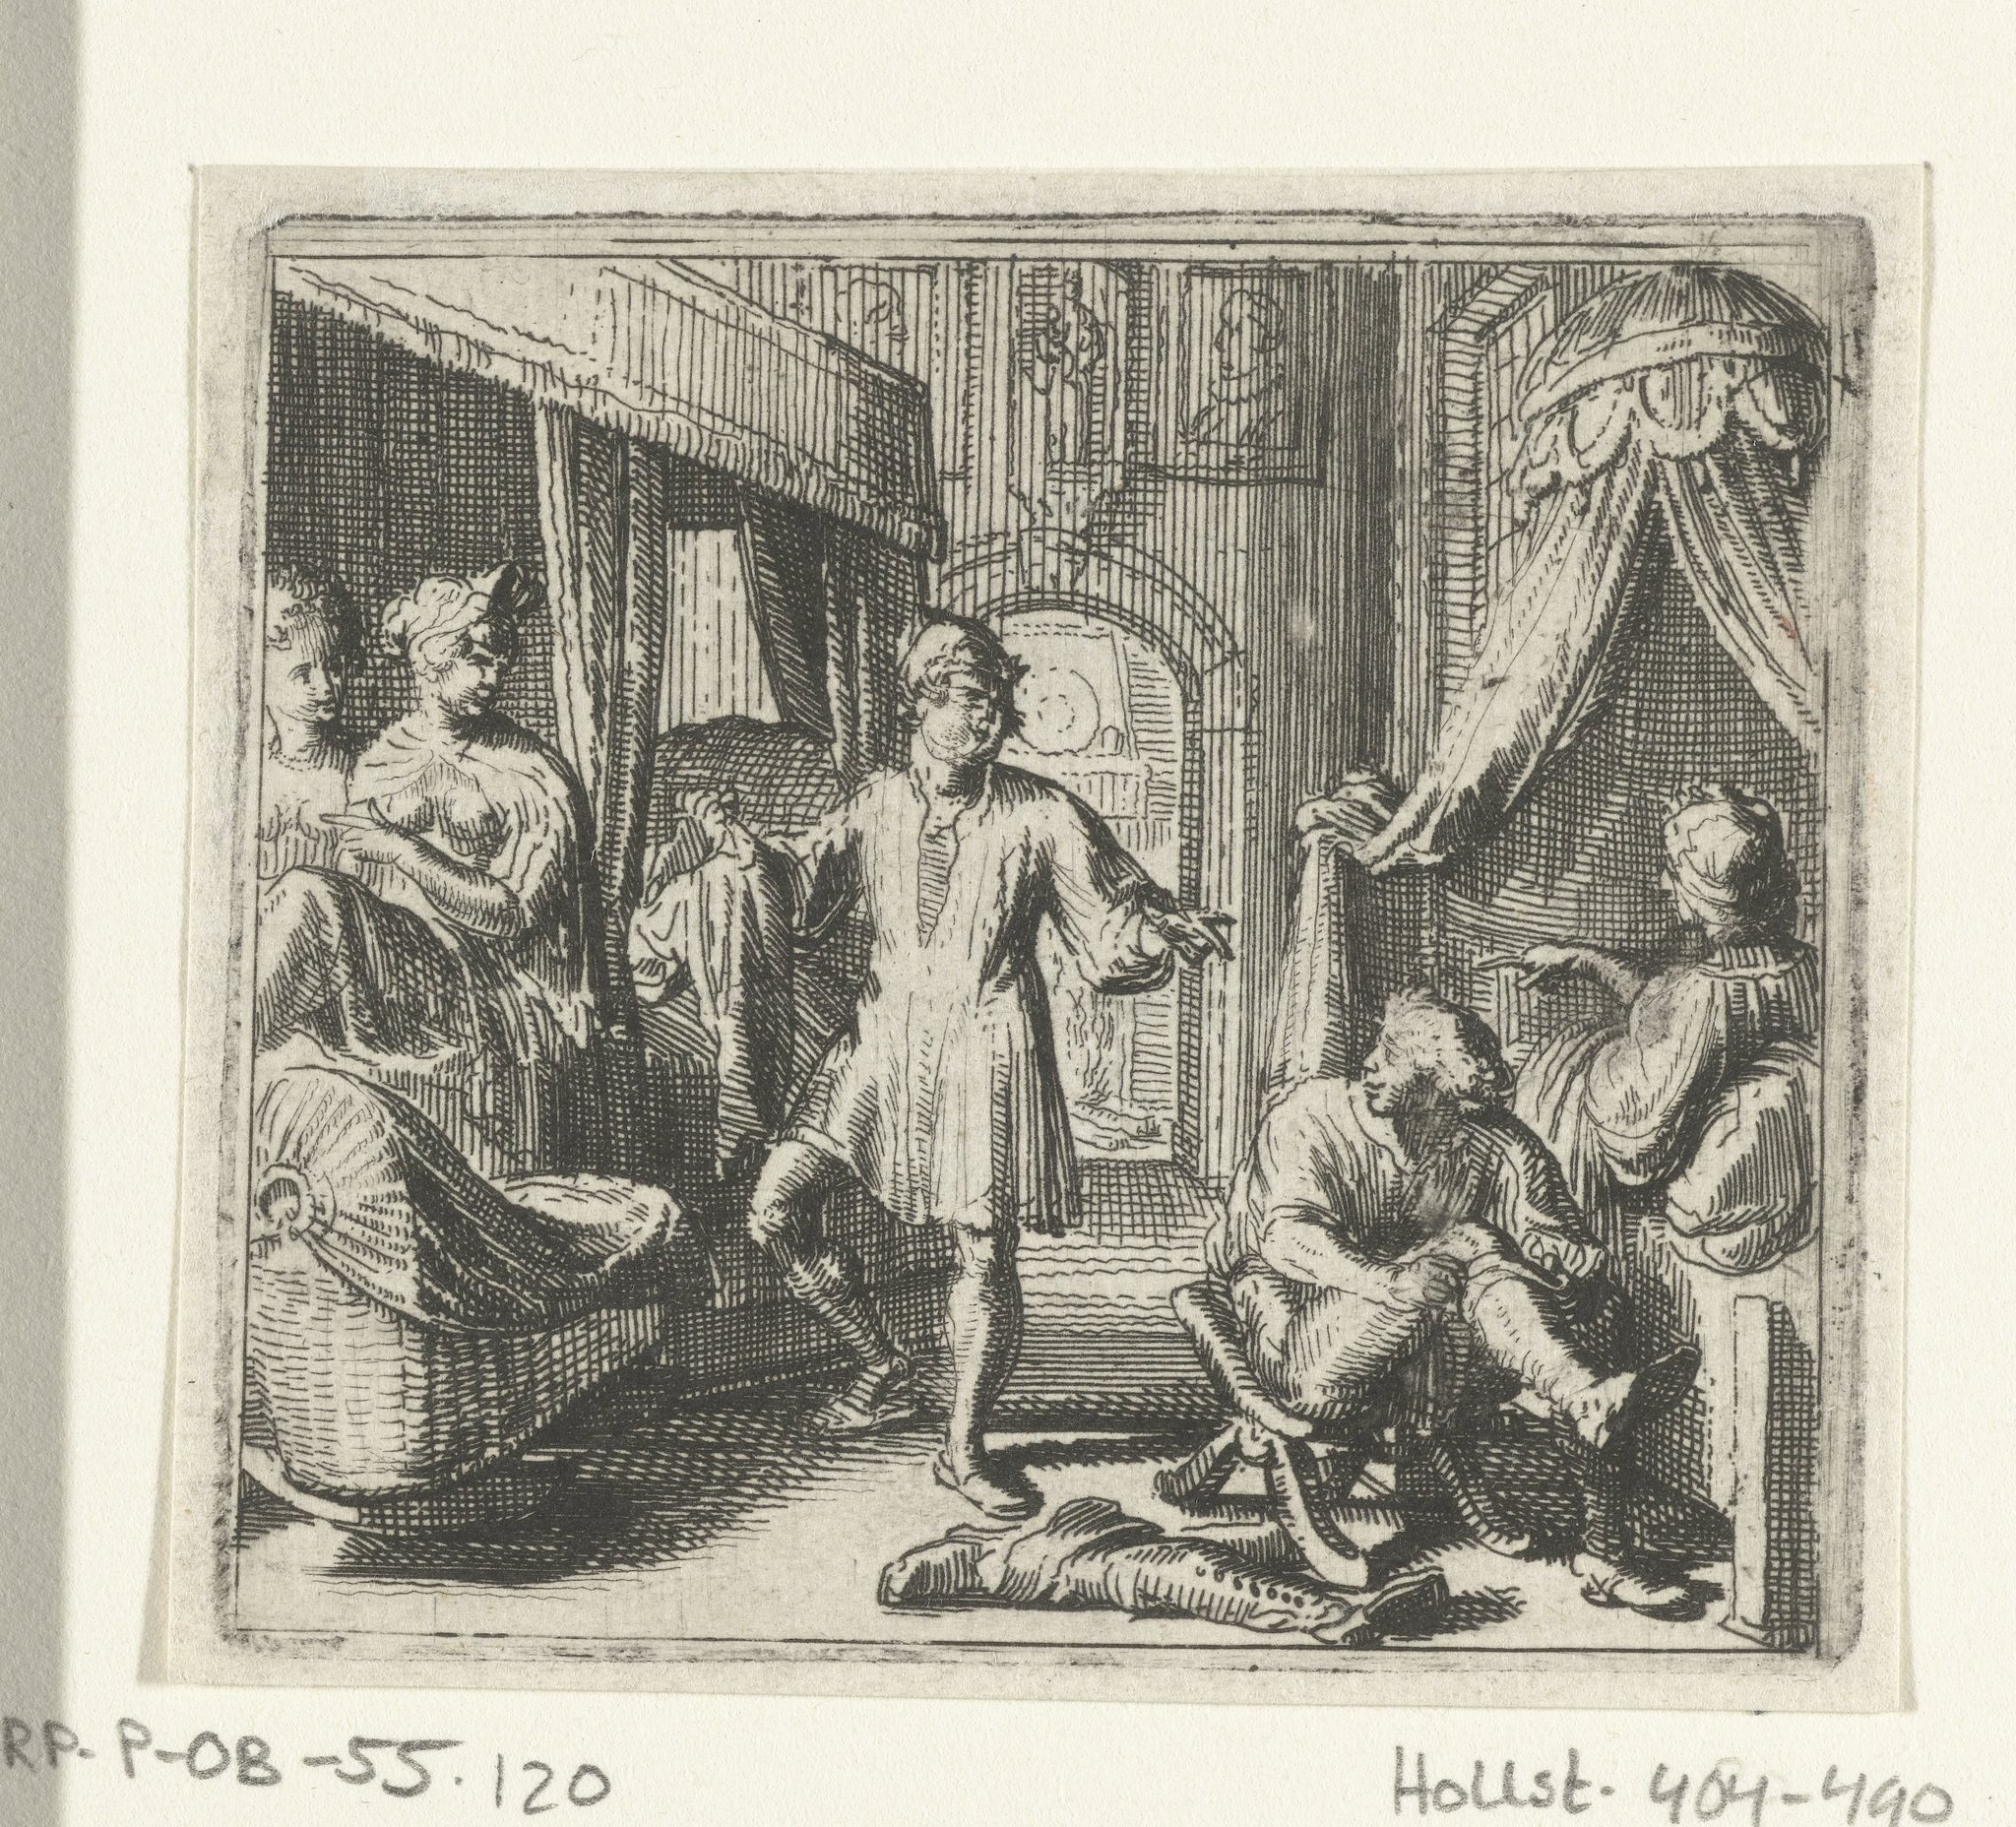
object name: book illustration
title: Illustratie voor de Decamerone van Boccaccio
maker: romeyn de hooghe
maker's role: draughtsman, goldsmith, painter, print maker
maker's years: 1645-1708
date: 1697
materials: paper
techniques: etching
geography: netherlands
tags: (scenes from) specific works of literature: boccaccio, decamerone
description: Illustratie voor de Decamerone van Boccaccio, historie LXXXVI. Een man staat tussen twee bedden. In het linker bed liggen twee vrouwen, in het rechter een man. Naast het rechter bed zit een jongeman.